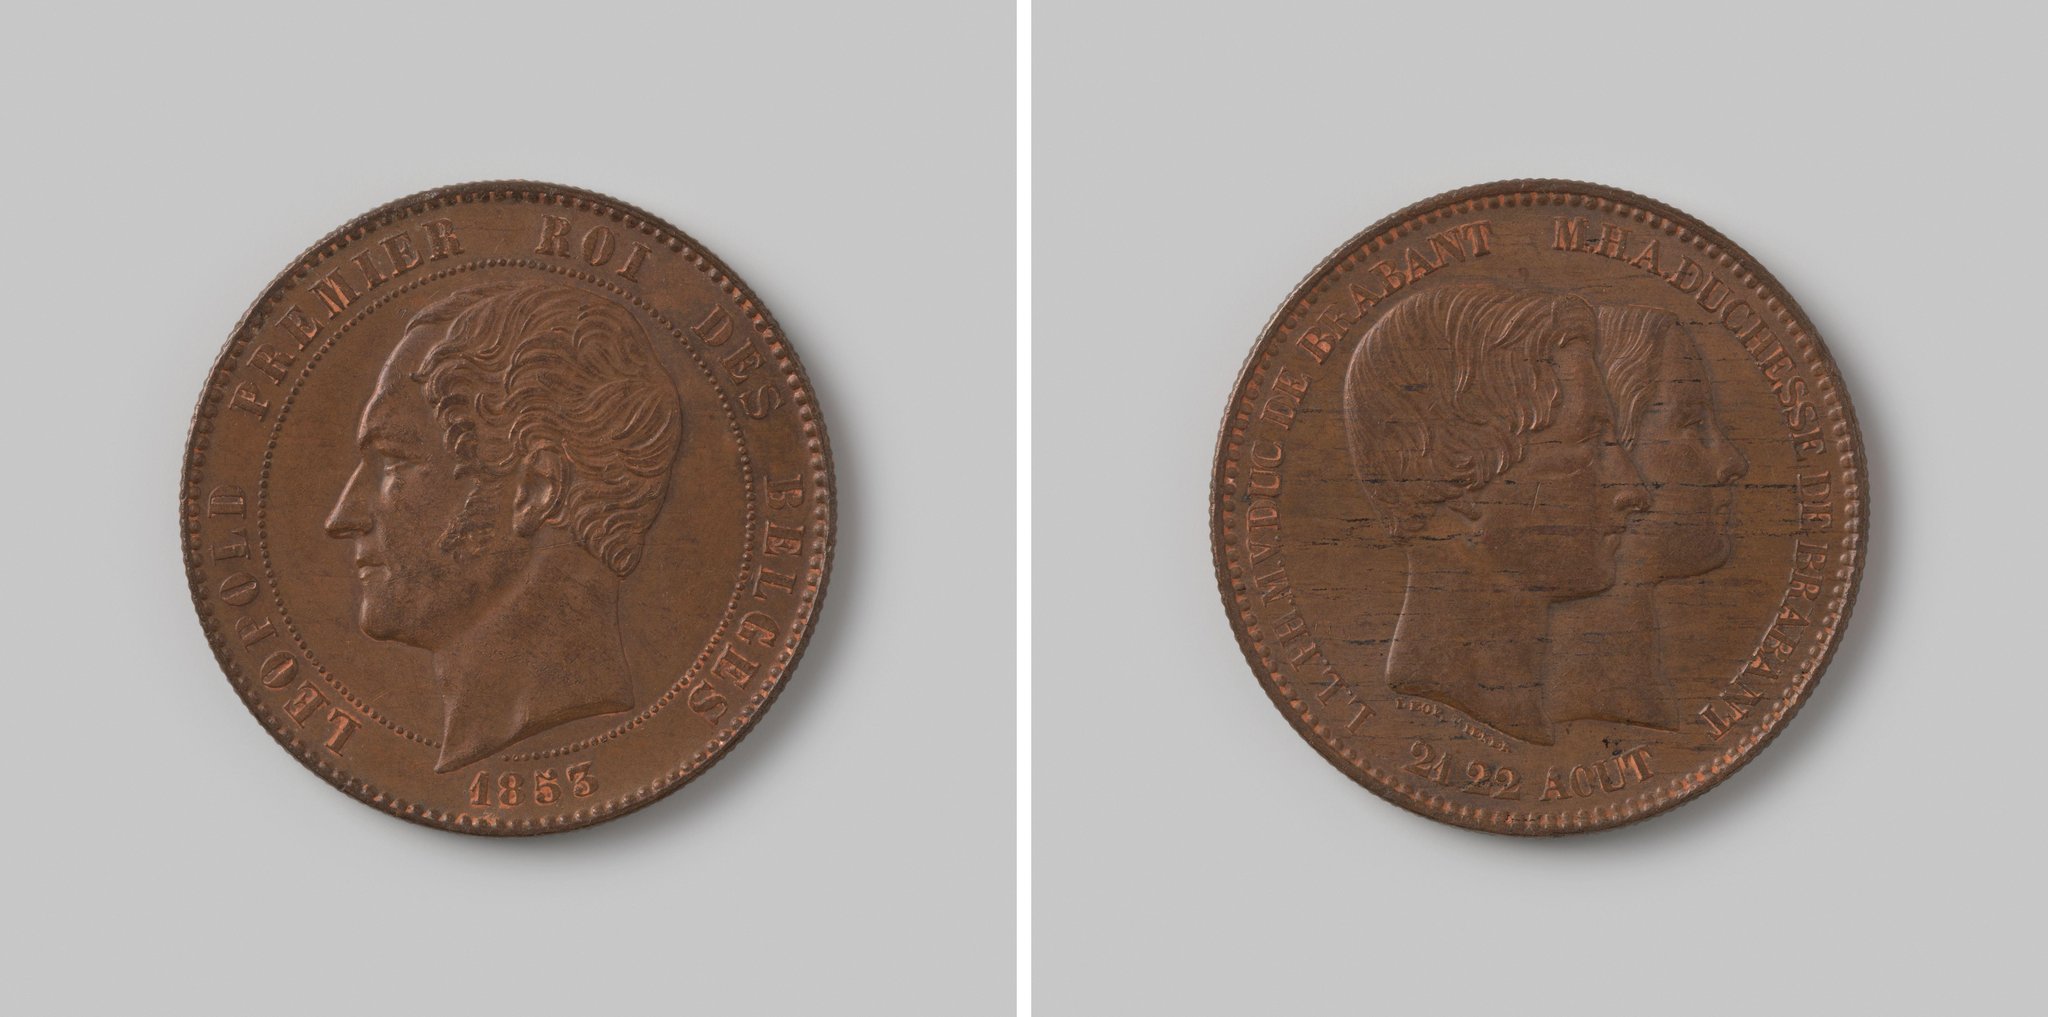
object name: history medal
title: Huwelijk van kroonprins Leopold van België met Maria Henriëtte van Hongarije 1853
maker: leopold wiener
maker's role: sculptor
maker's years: 1823-1891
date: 1853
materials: copper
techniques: striking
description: Koperen penning op het formaat van een 10-centimesstuk, op de voorzijde het portret van Koning Leopold I met omschrift, op de keerzijde een dubbelportret van het bruidspaar met omschrift, met kartelrand.